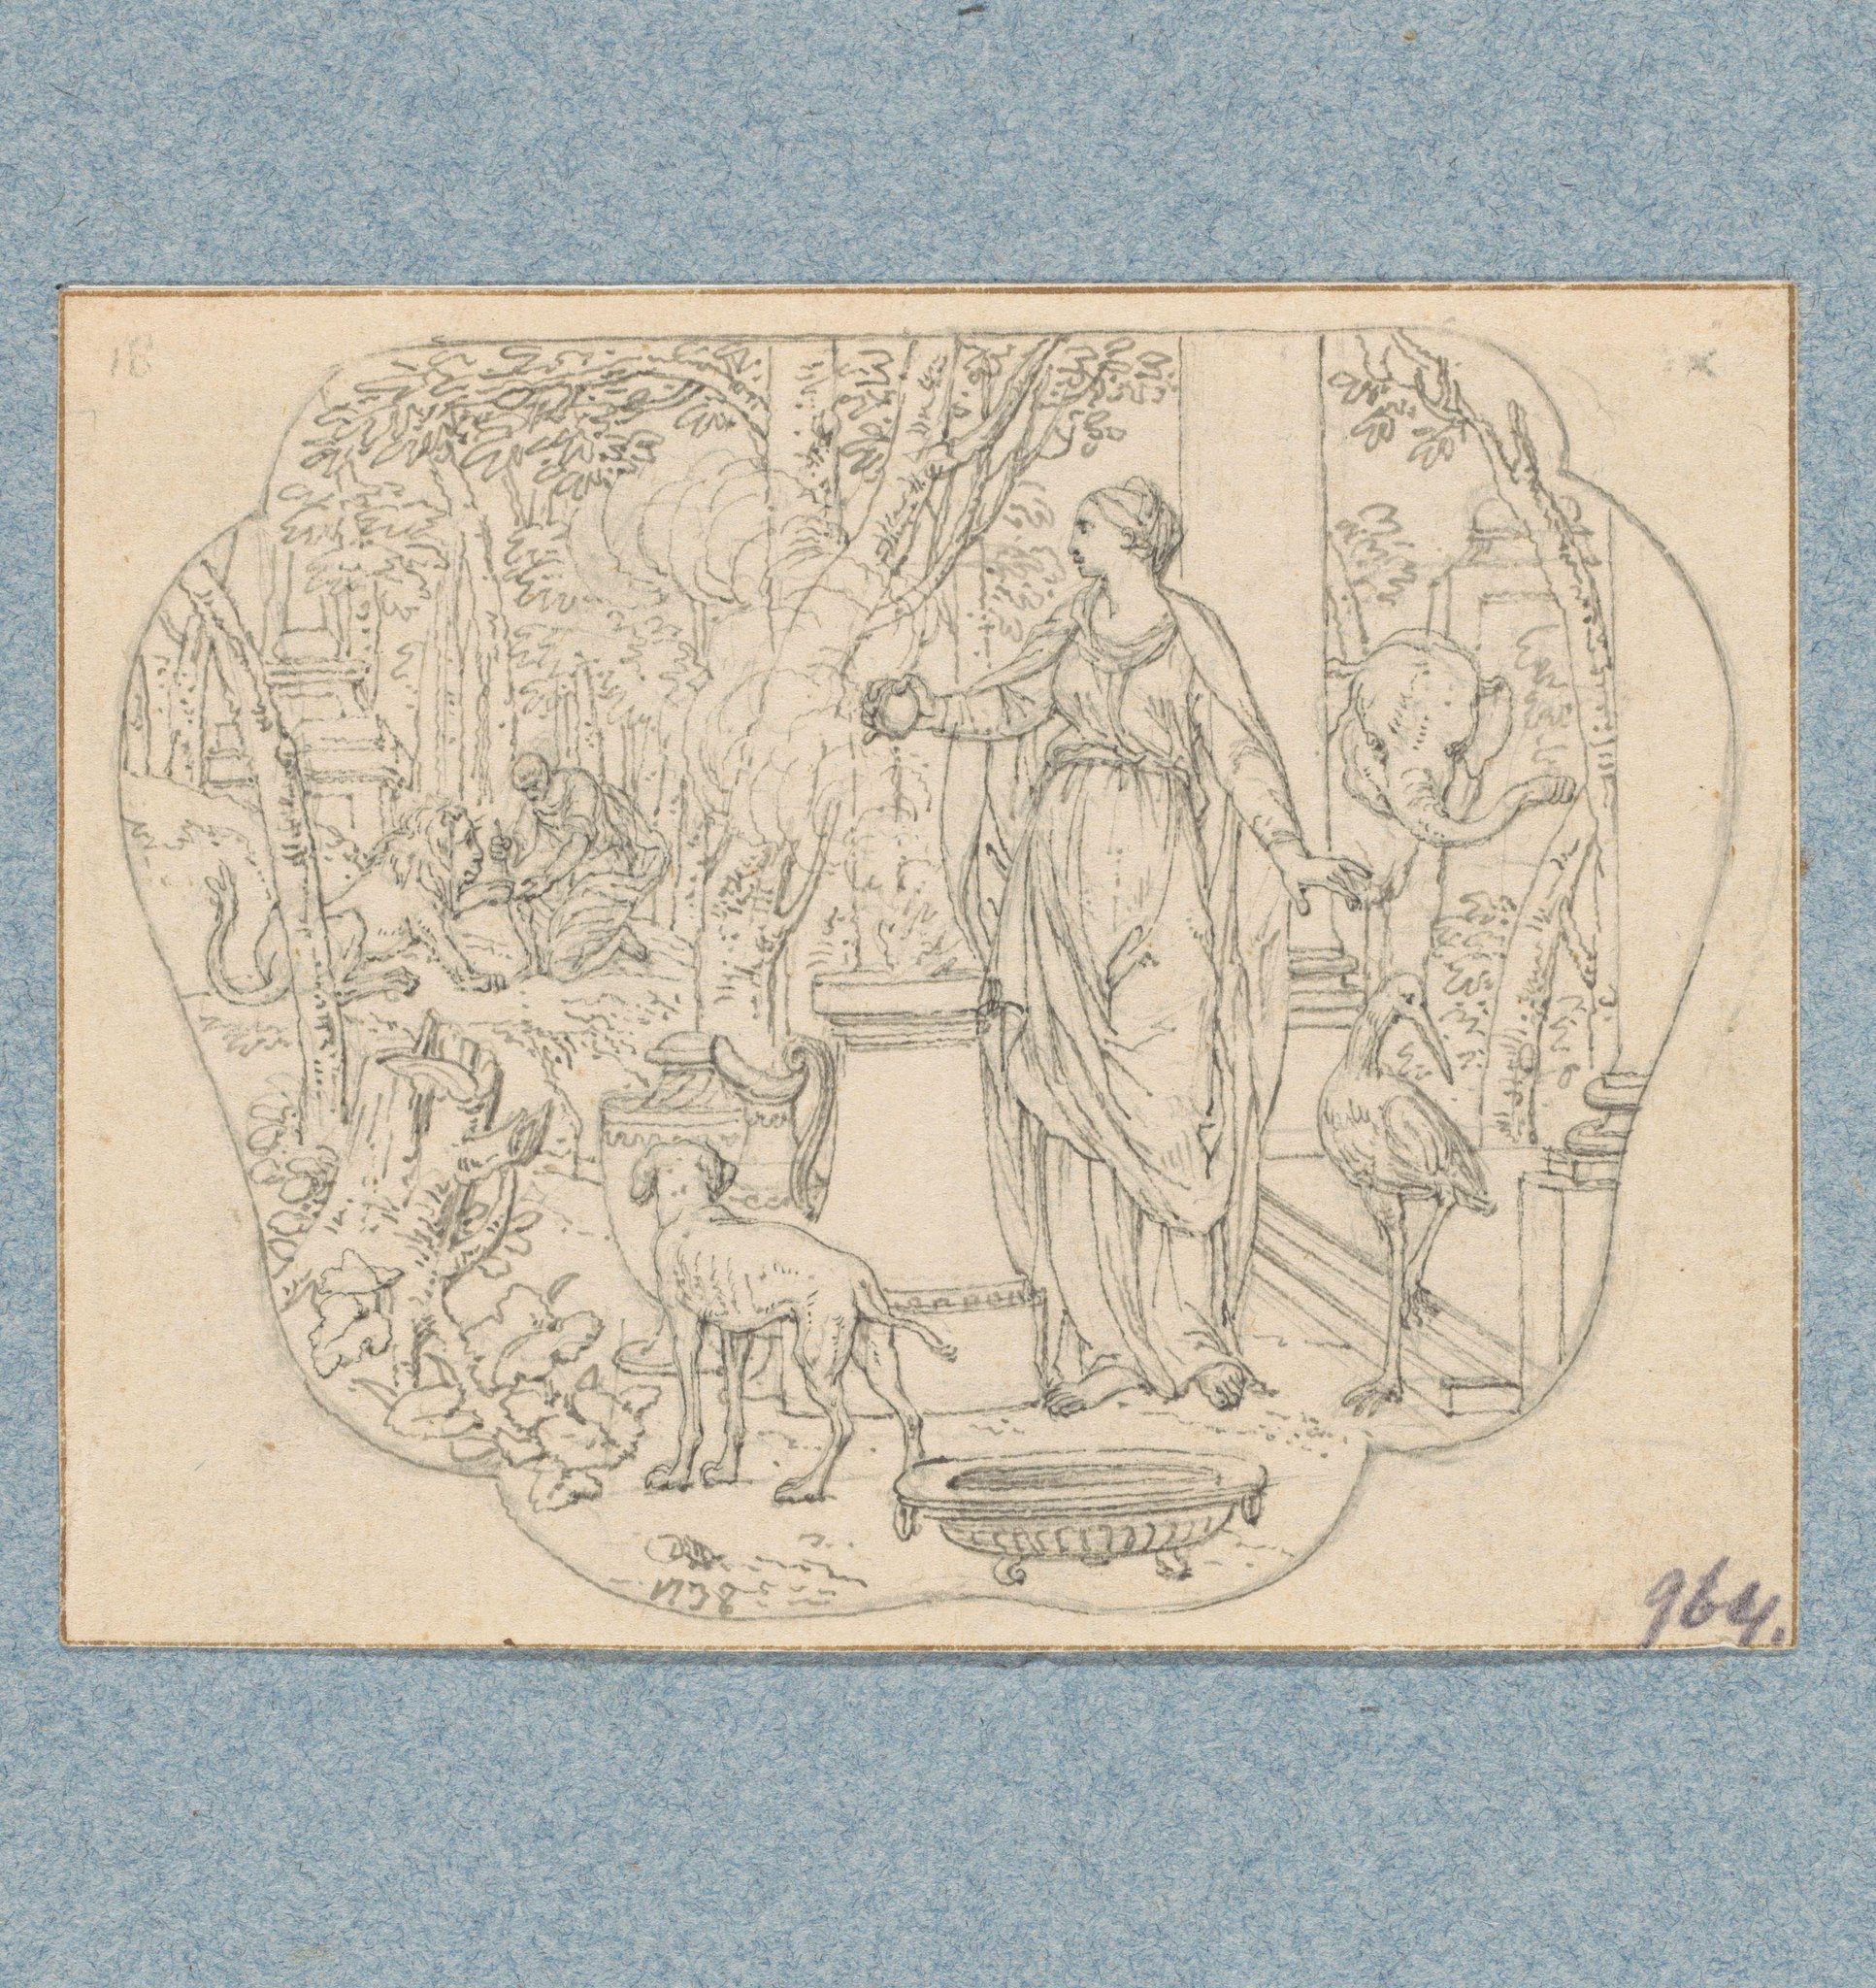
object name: drawing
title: Pietas (in doos met 43 tekeningen)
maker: louis fabritius dubourg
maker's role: draughtsman, print maker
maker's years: 1693-1775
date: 1738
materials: ink, paper, pencil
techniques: pen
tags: 'pietas'; 'pietà' (ripa)